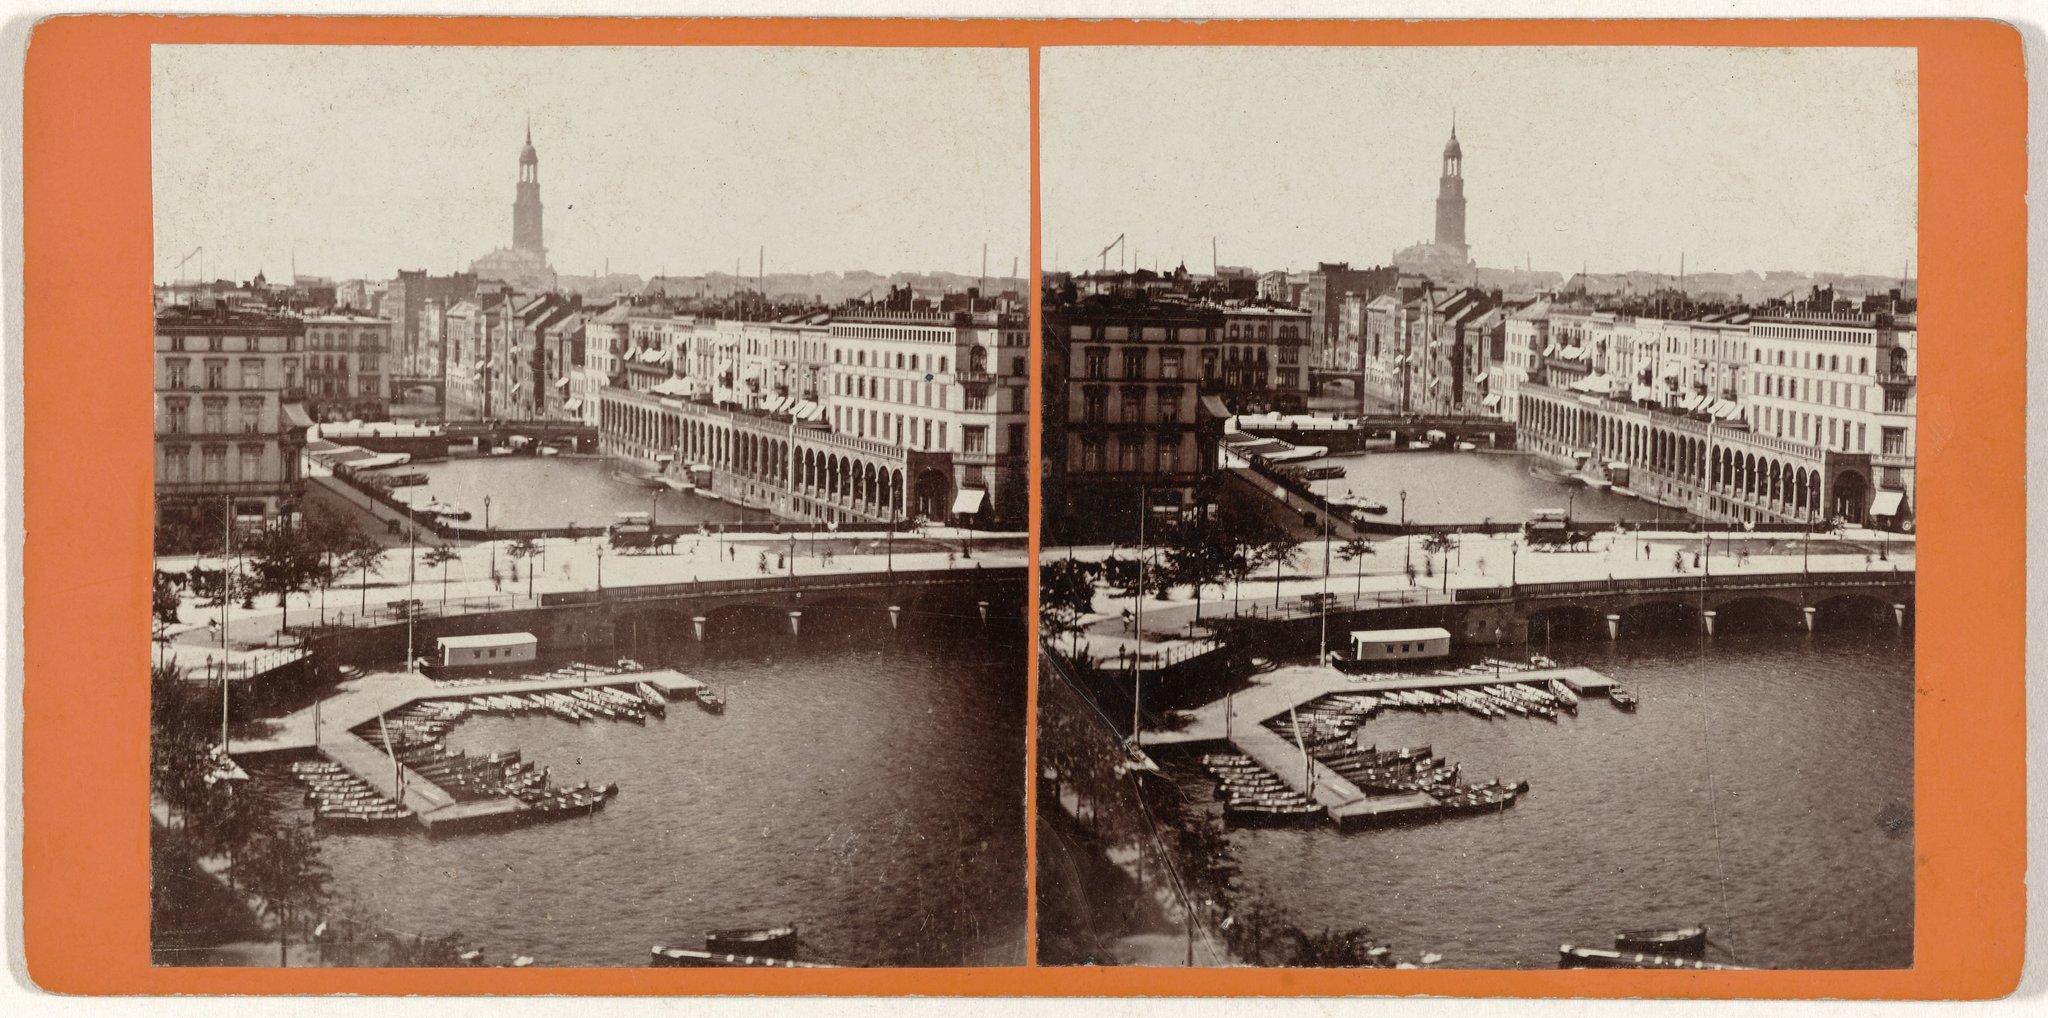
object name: stereograph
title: Gezicht op de Alterarkaden in Hamburg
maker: Anonymous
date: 1873-1890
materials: cardboard, photographic support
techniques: collodion silver print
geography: hamburg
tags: city-view in general; 'veduta', canals, waters (in city), arcade ~ architecture